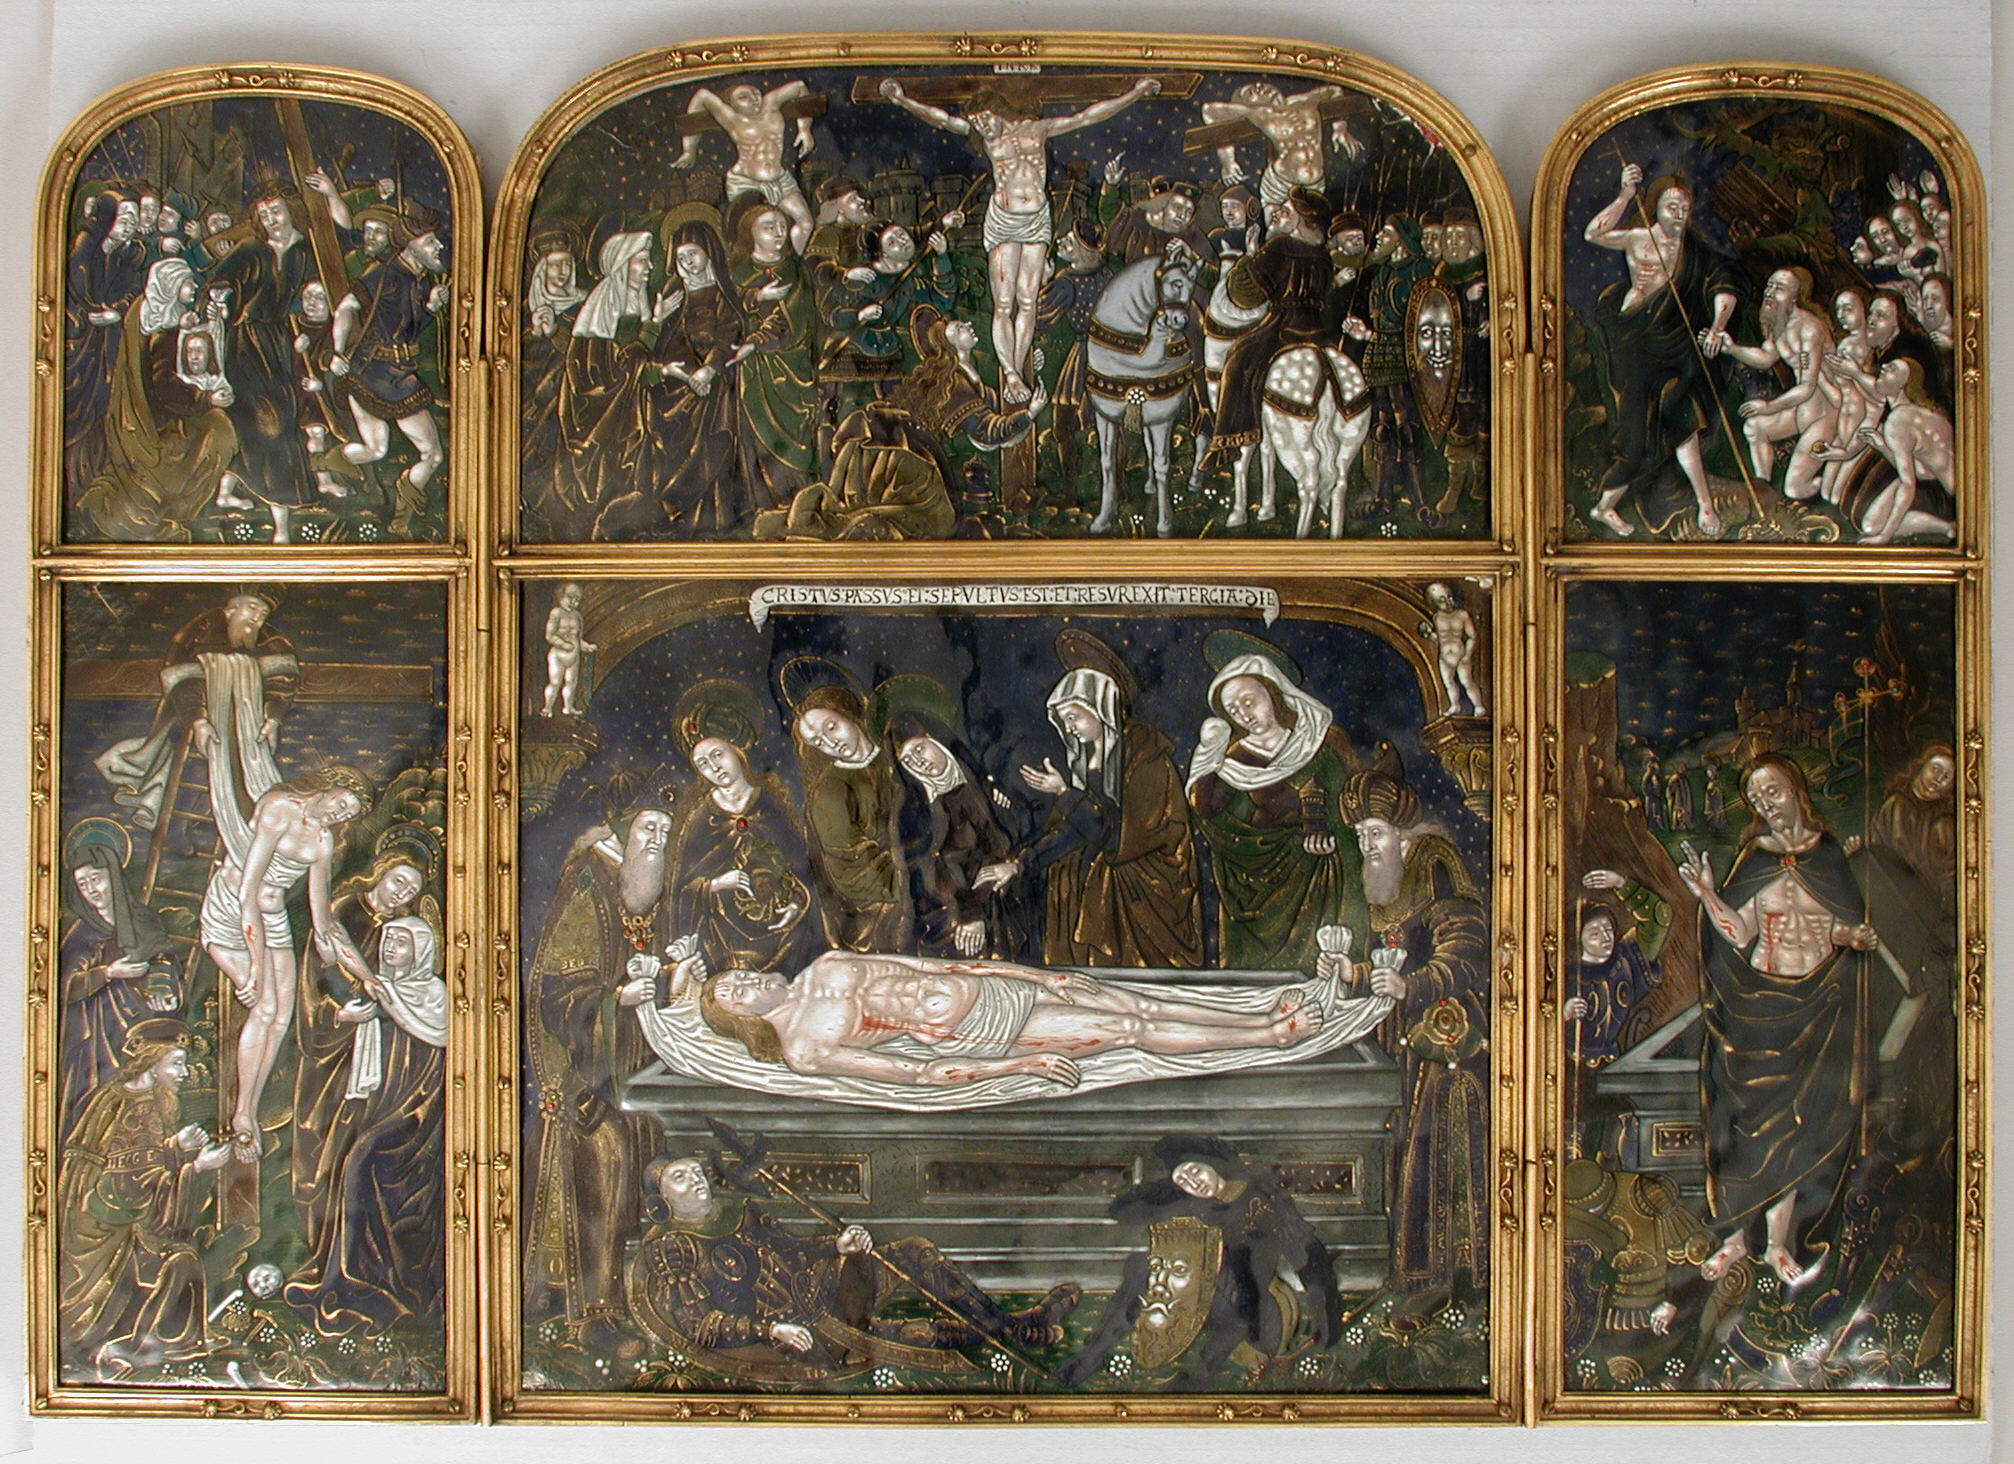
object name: triptych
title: Triptych with the Entombment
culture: french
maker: nardon pénicaud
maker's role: artist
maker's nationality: french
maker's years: 1470-1543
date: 1501-1600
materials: copper, enamel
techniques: painting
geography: france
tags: christ,bearing the cross,descent from the cross,entombment